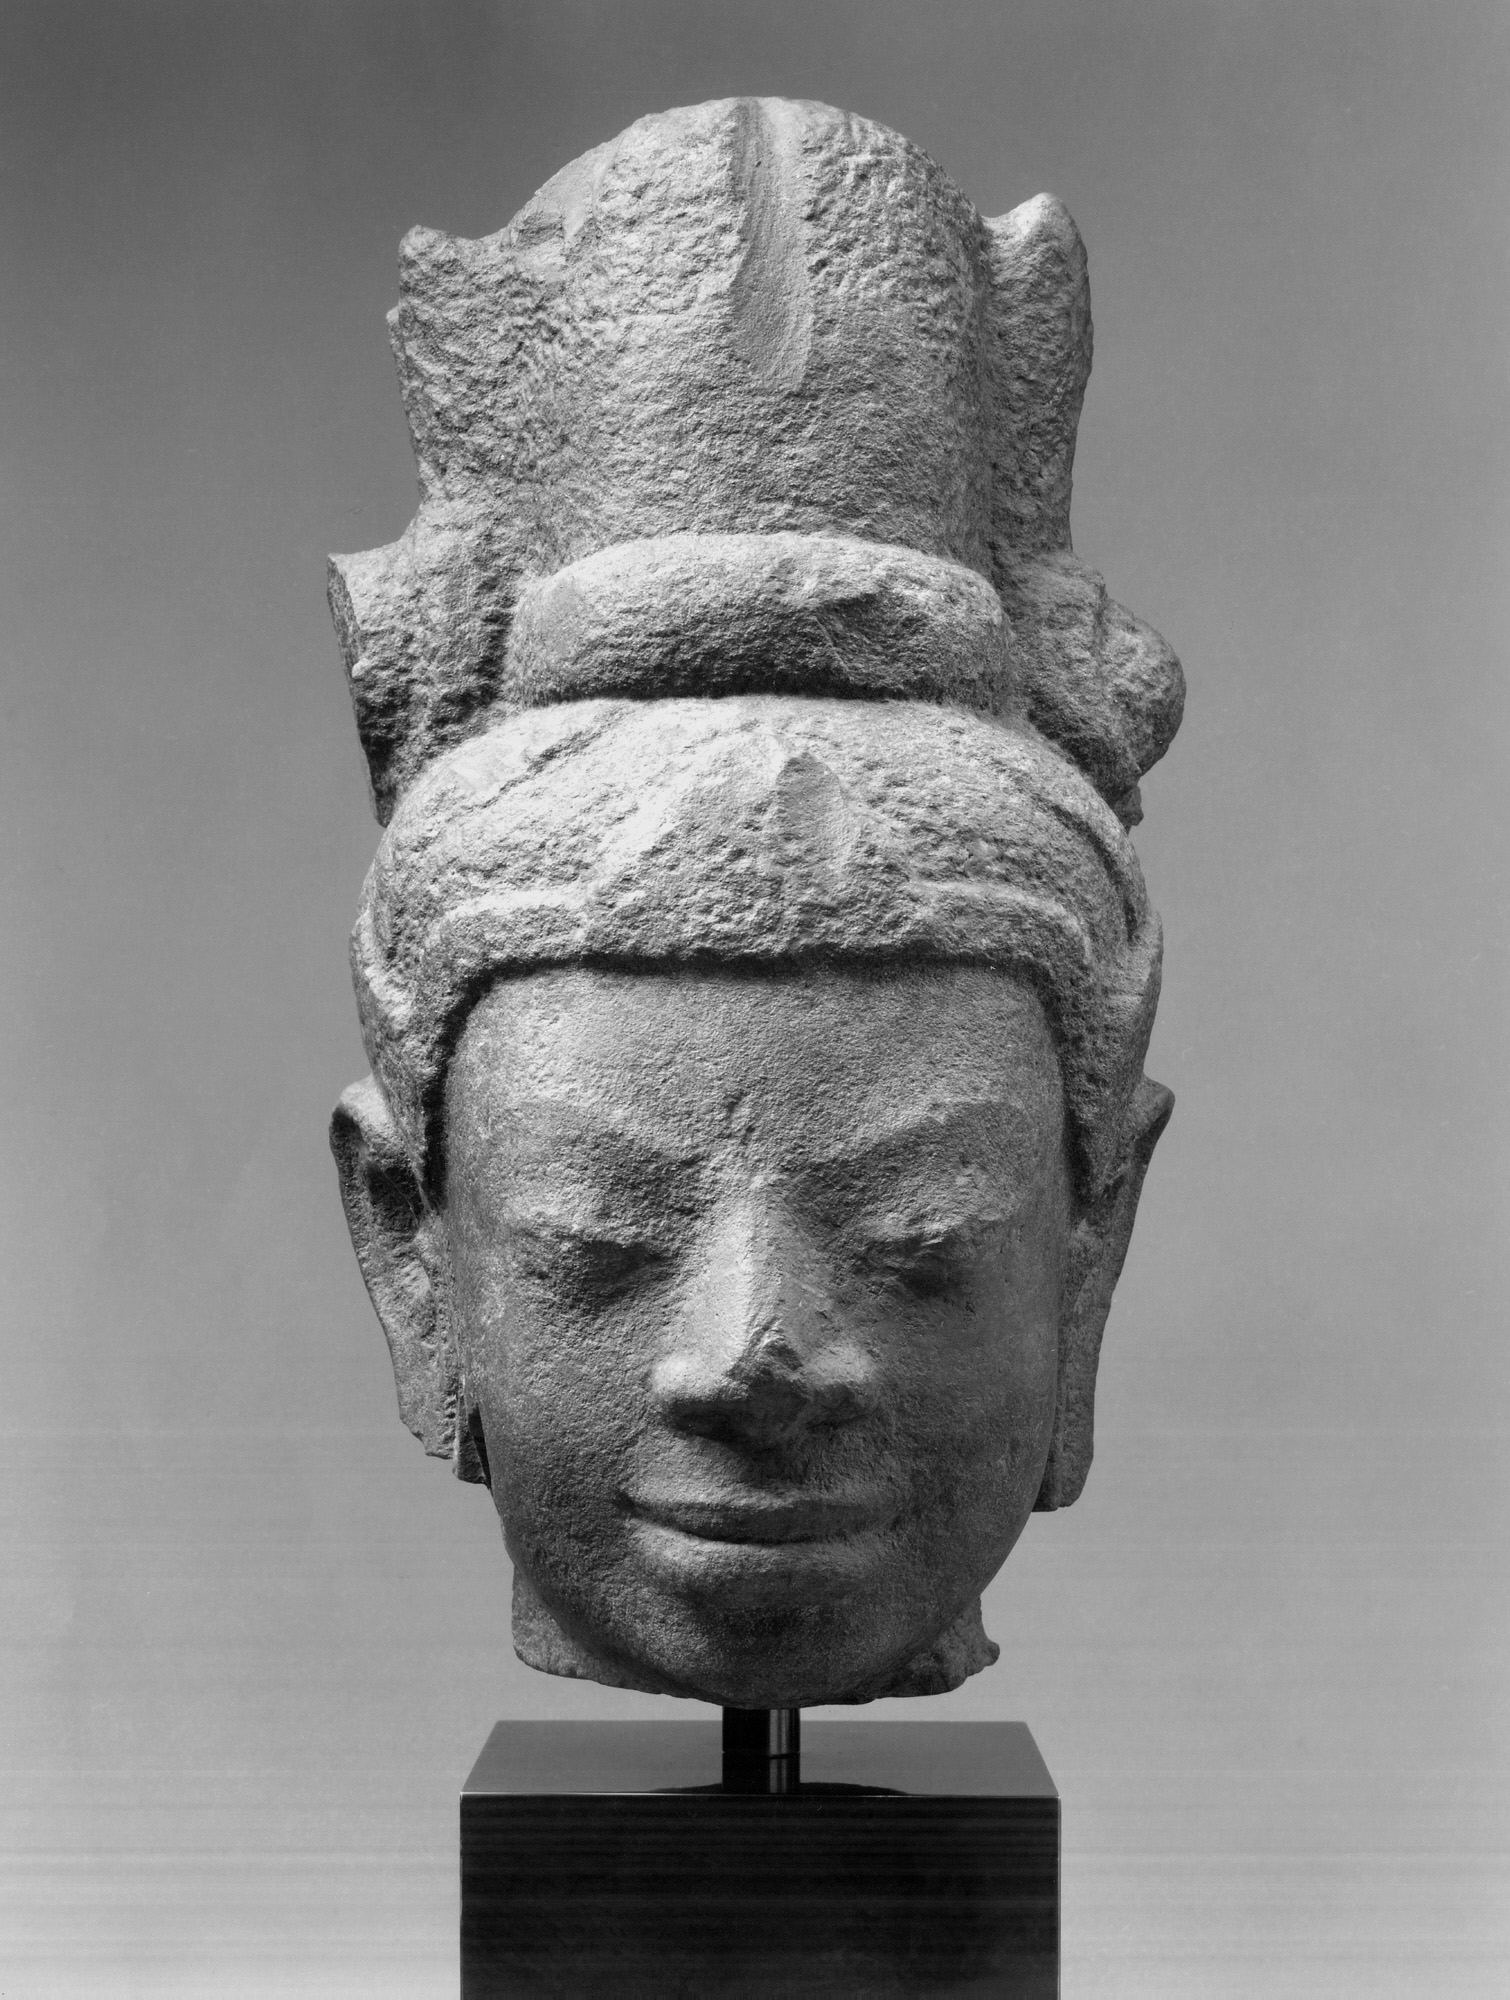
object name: head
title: Head of a Bodhisattva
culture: thai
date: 701-750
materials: stone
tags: heads,buddhism,bodhisattvas